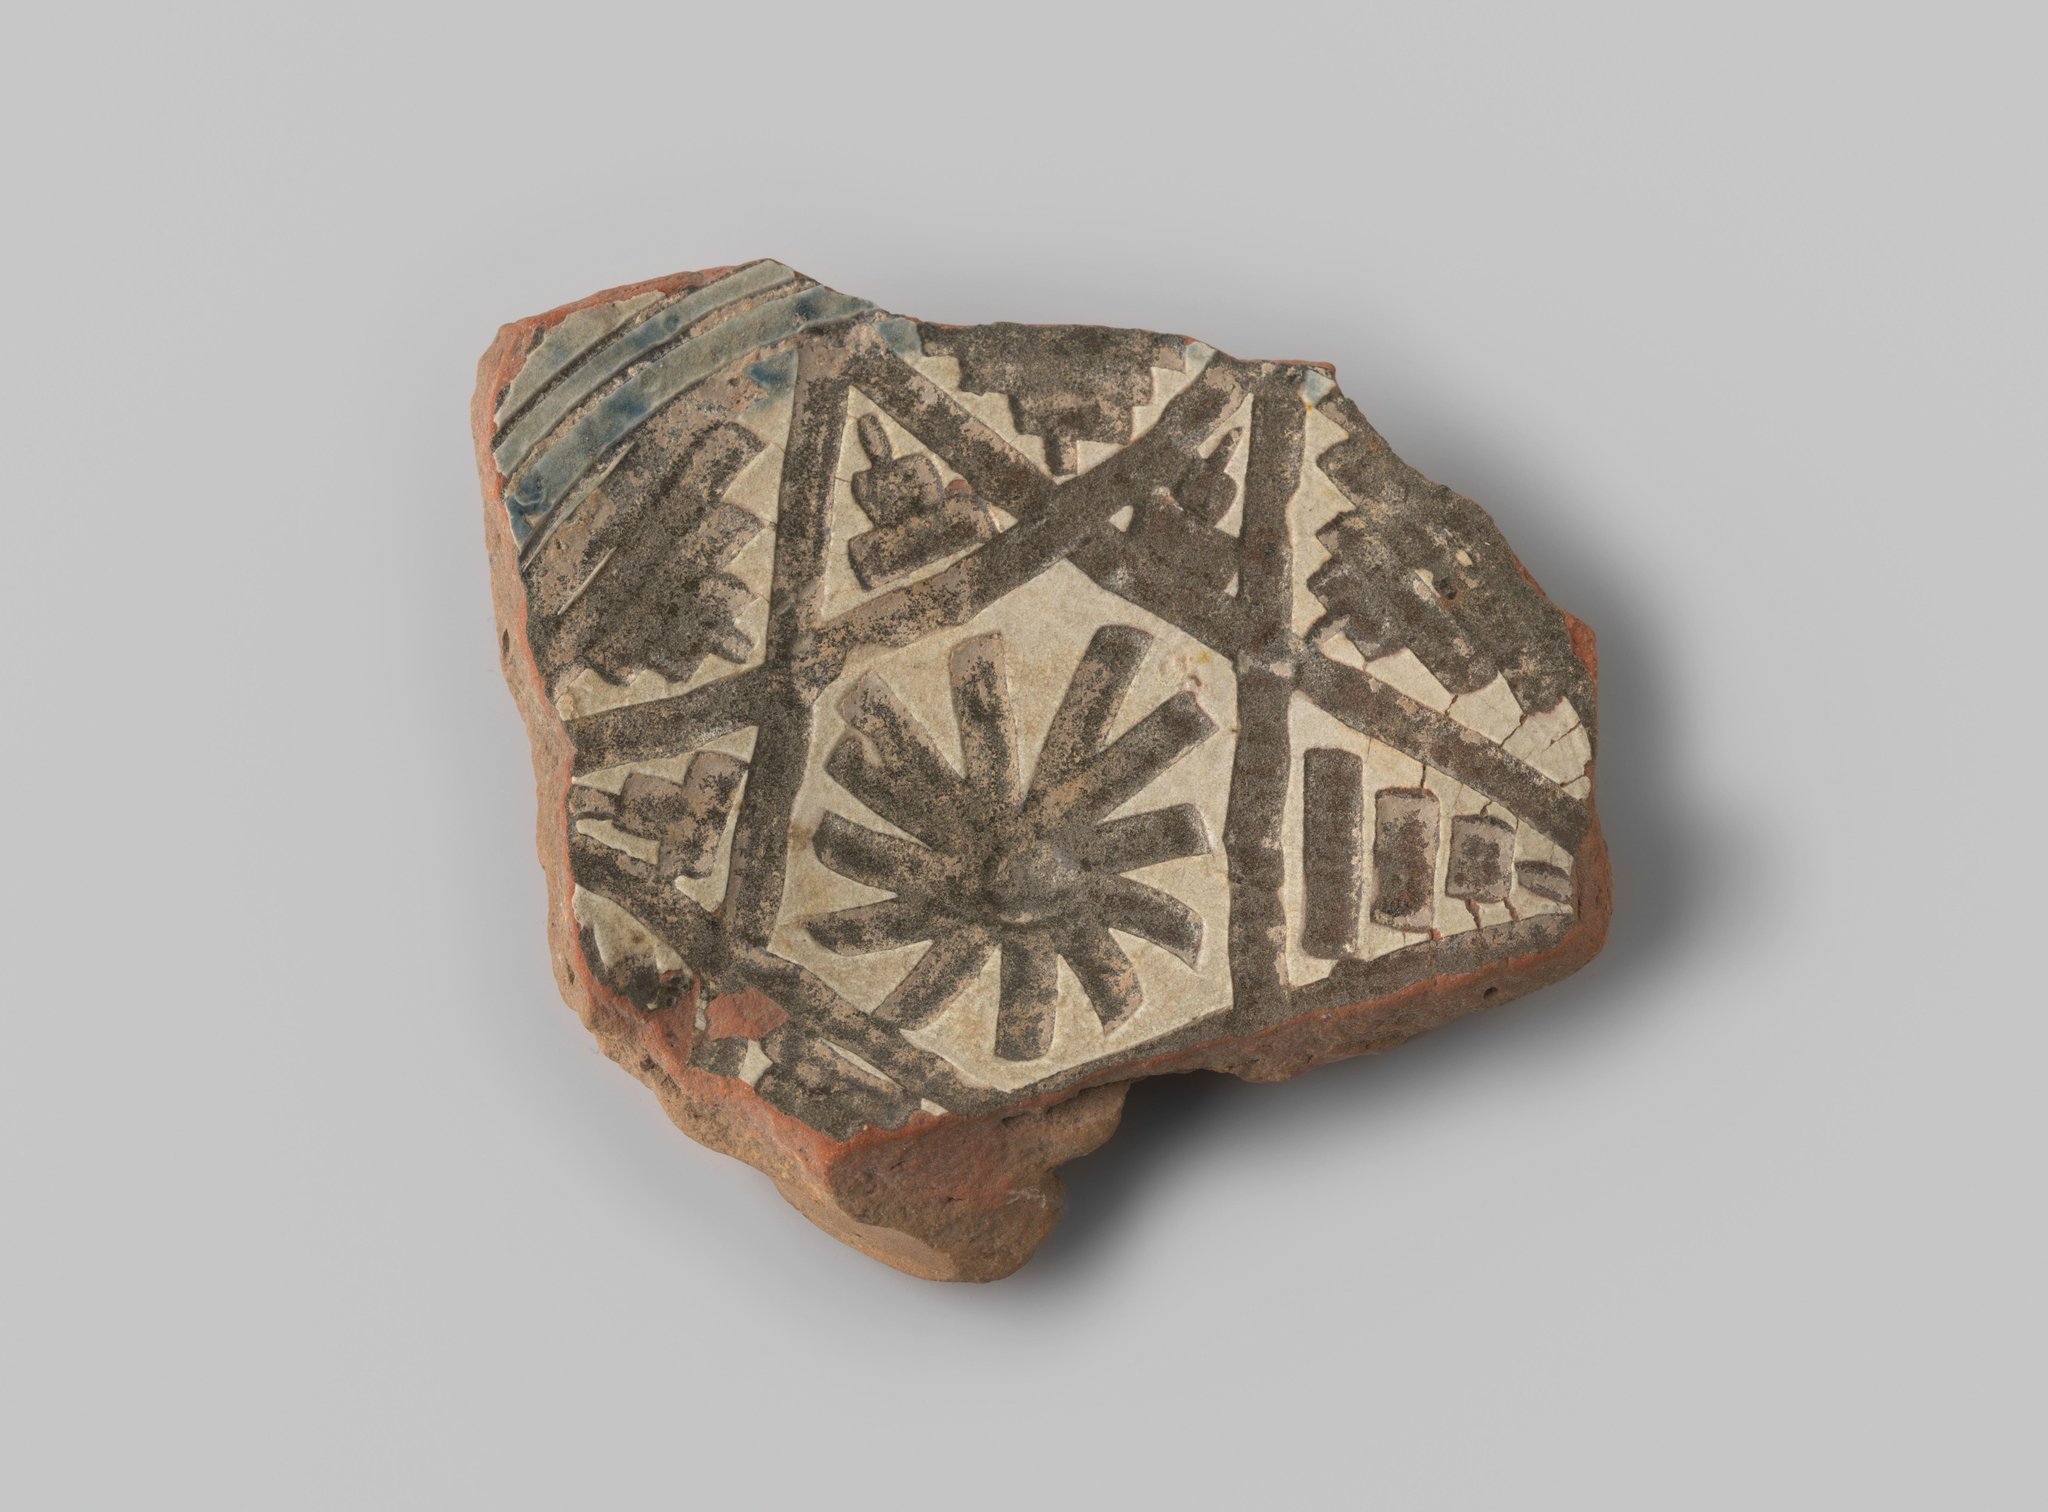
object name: sherd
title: Fragment (voet) met rode scherf, met een decoratie van strepen en sterren in sgraffito-techniek in wit en zwart aan de bovenzijde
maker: Anonymous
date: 1200-1899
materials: earthenware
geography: italy